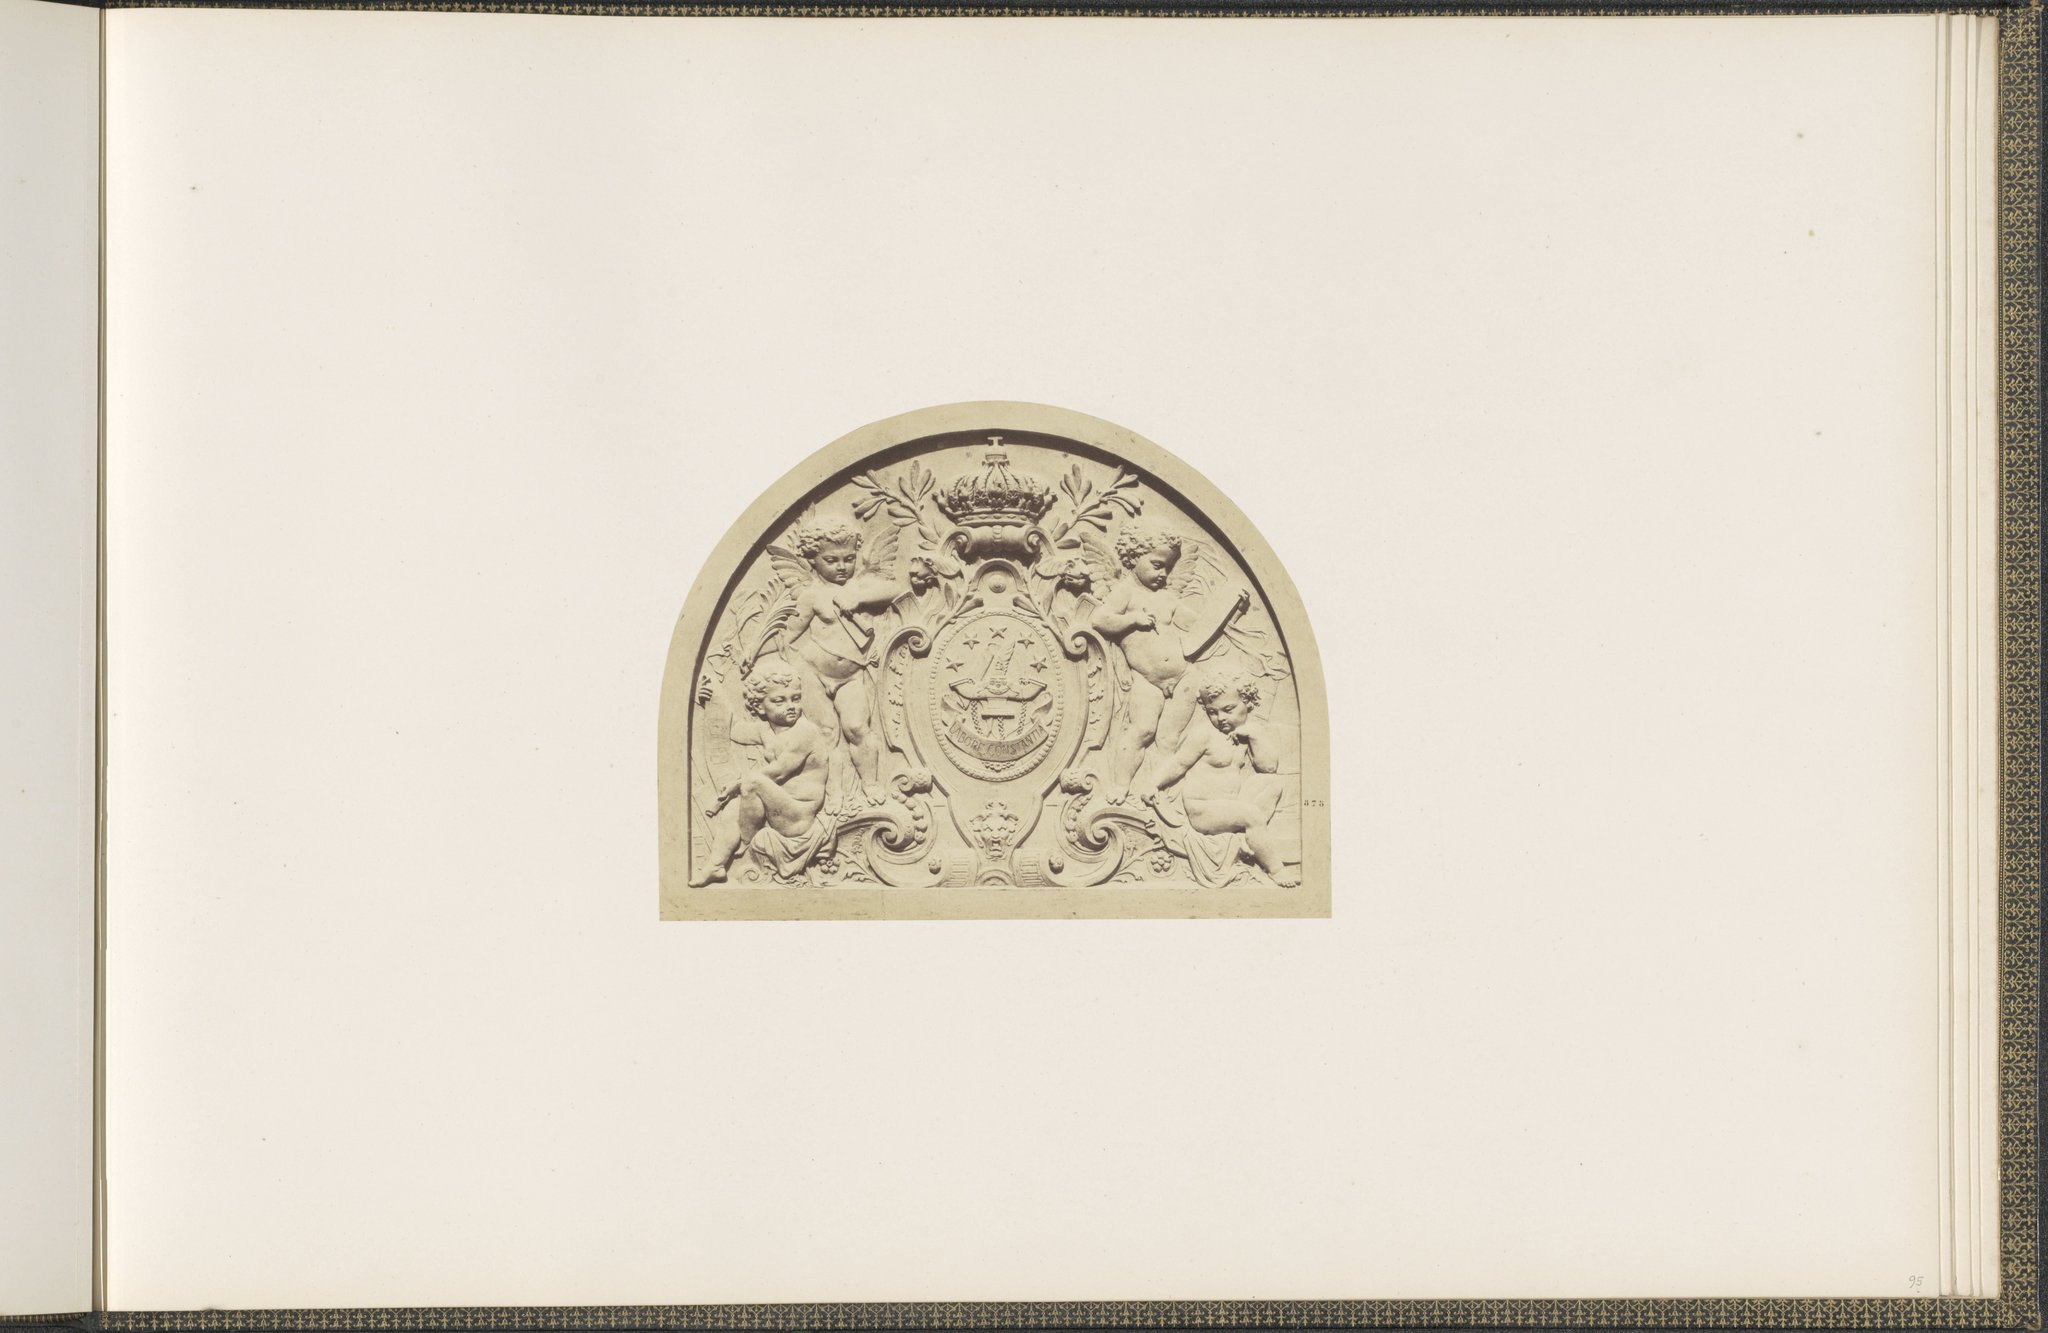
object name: photograph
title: Gipsmodel voor beeldhouwwerk op het Palais du Louvre: "L'Etude" door François Gilbert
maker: édouard denis baldus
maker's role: fotograaf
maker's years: 1813-1889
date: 1855-1857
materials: paper, photographic support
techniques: salted paper print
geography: paris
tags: piece of sculpture, reproduction of a piece of sculpture, permanent exhibition, museum, paris, tuileries palace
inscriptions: number: ‘875’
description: Onderdeel van Réunion des Tuileries au Louvre 1852-1857, album 4.